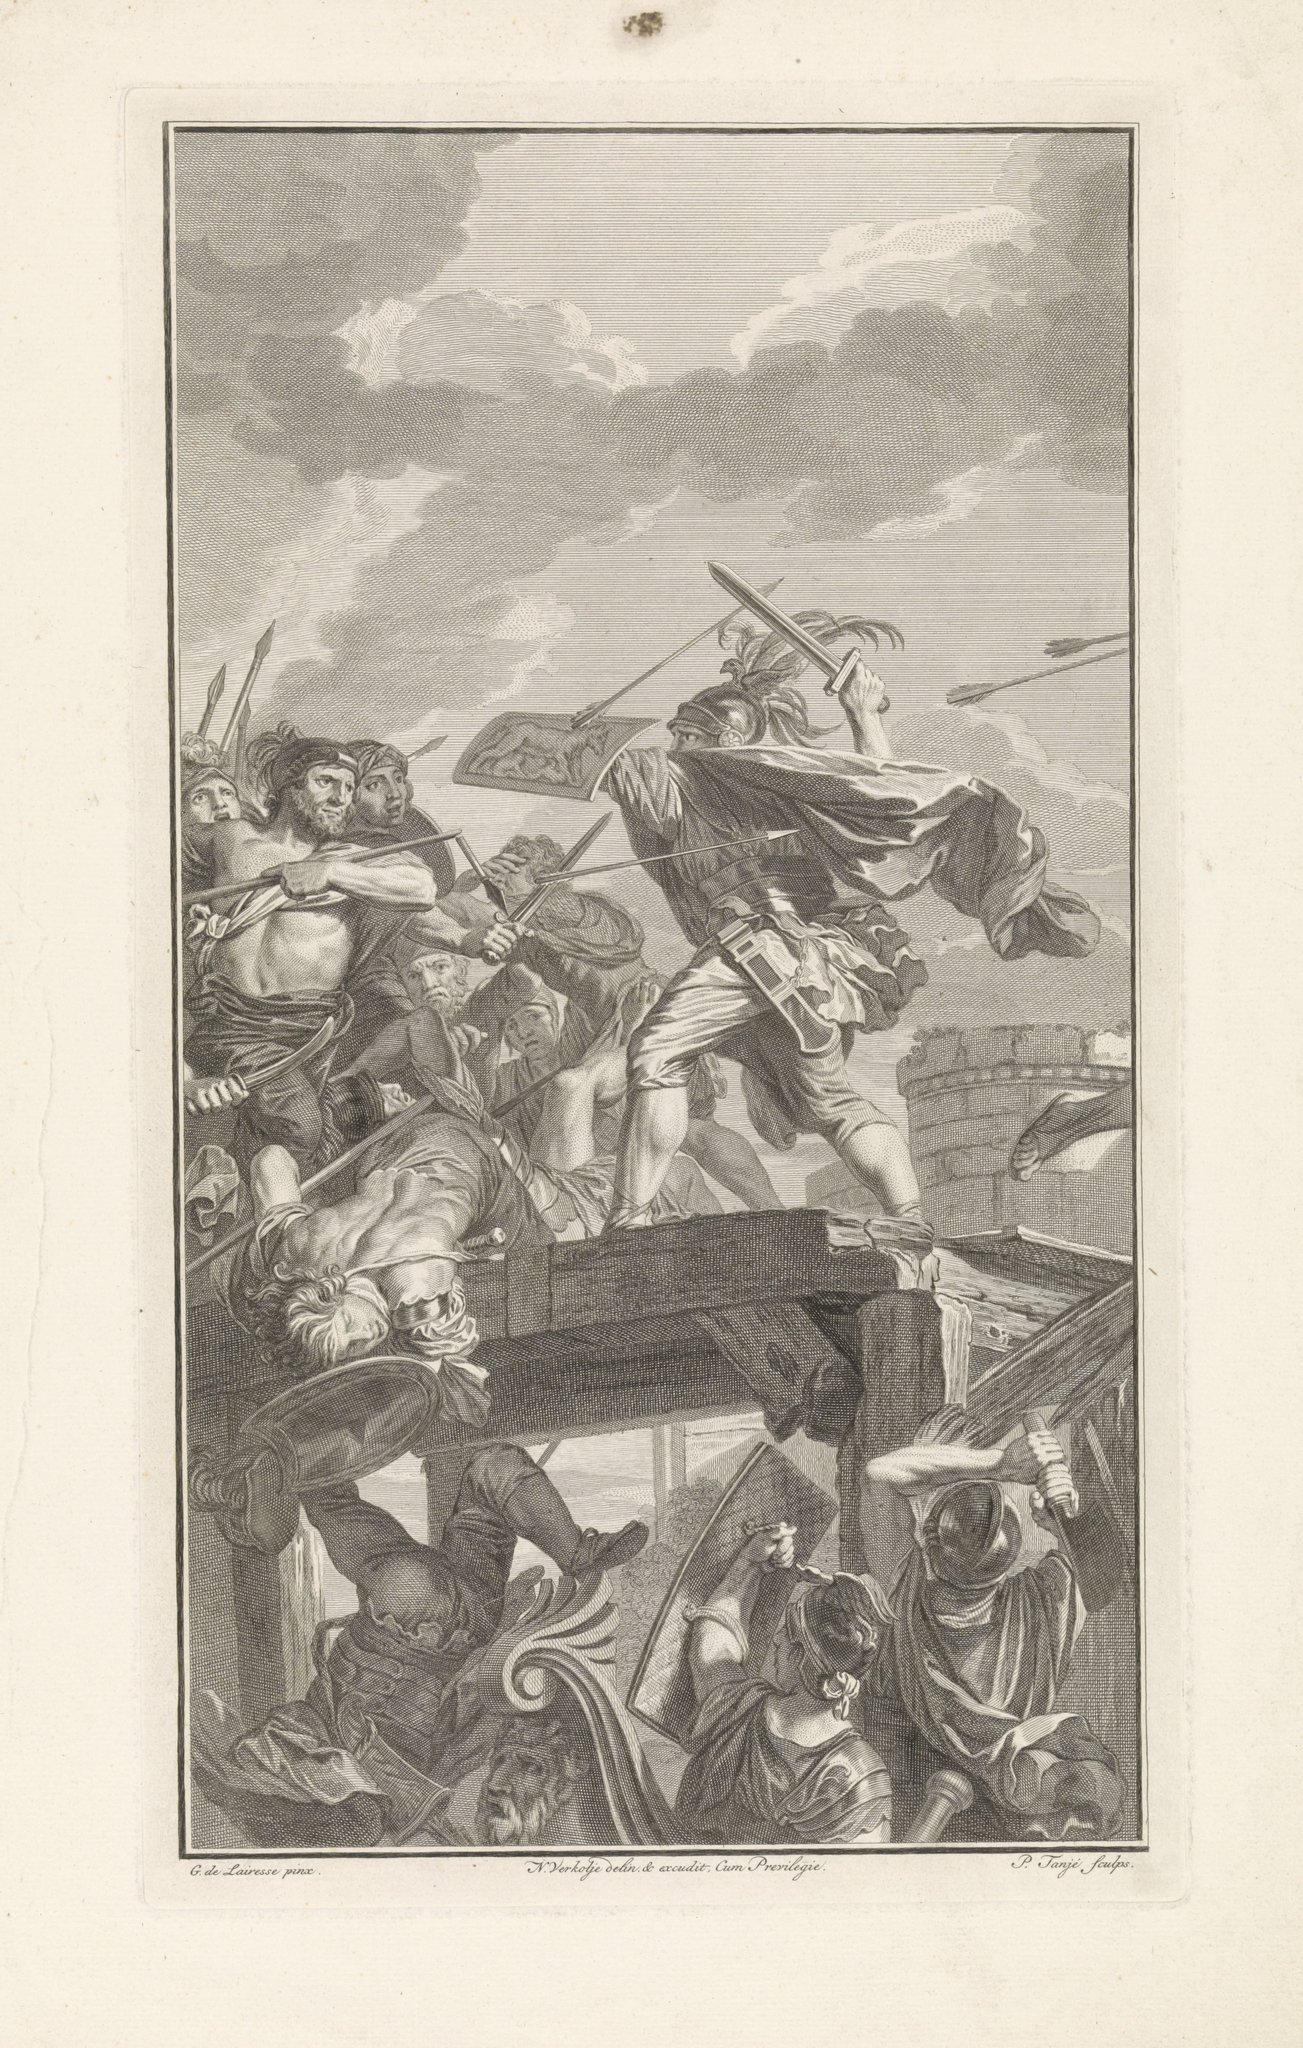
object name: print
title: Tafereelen, (...) in de raadkamer van den hove van justitie van Holland, Zeeland, en Westvriesland (...)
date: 1737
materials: paper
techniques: engraving, etching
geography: amsterdam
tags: horatius cocles at the pons sublicius: single-handed he keeps the etruscans at bay while the bridge is broken down by the romans behind him; he escapes by jumping into the tiber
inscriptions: collector's mark: Lugt 2228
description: Horatius Coclus voorkwam dat Rome werd veroverd door Etruskische troepen, door op op een houten brug over de Tiber de aanvallers af te weren. Achter hem breken Romeinse soldaten de brug af. Voorstelling in de Raadkamer van het Hof van Justitie van Holland, Zeeland en West-Friesland in het Binnenhof te Den Haag.